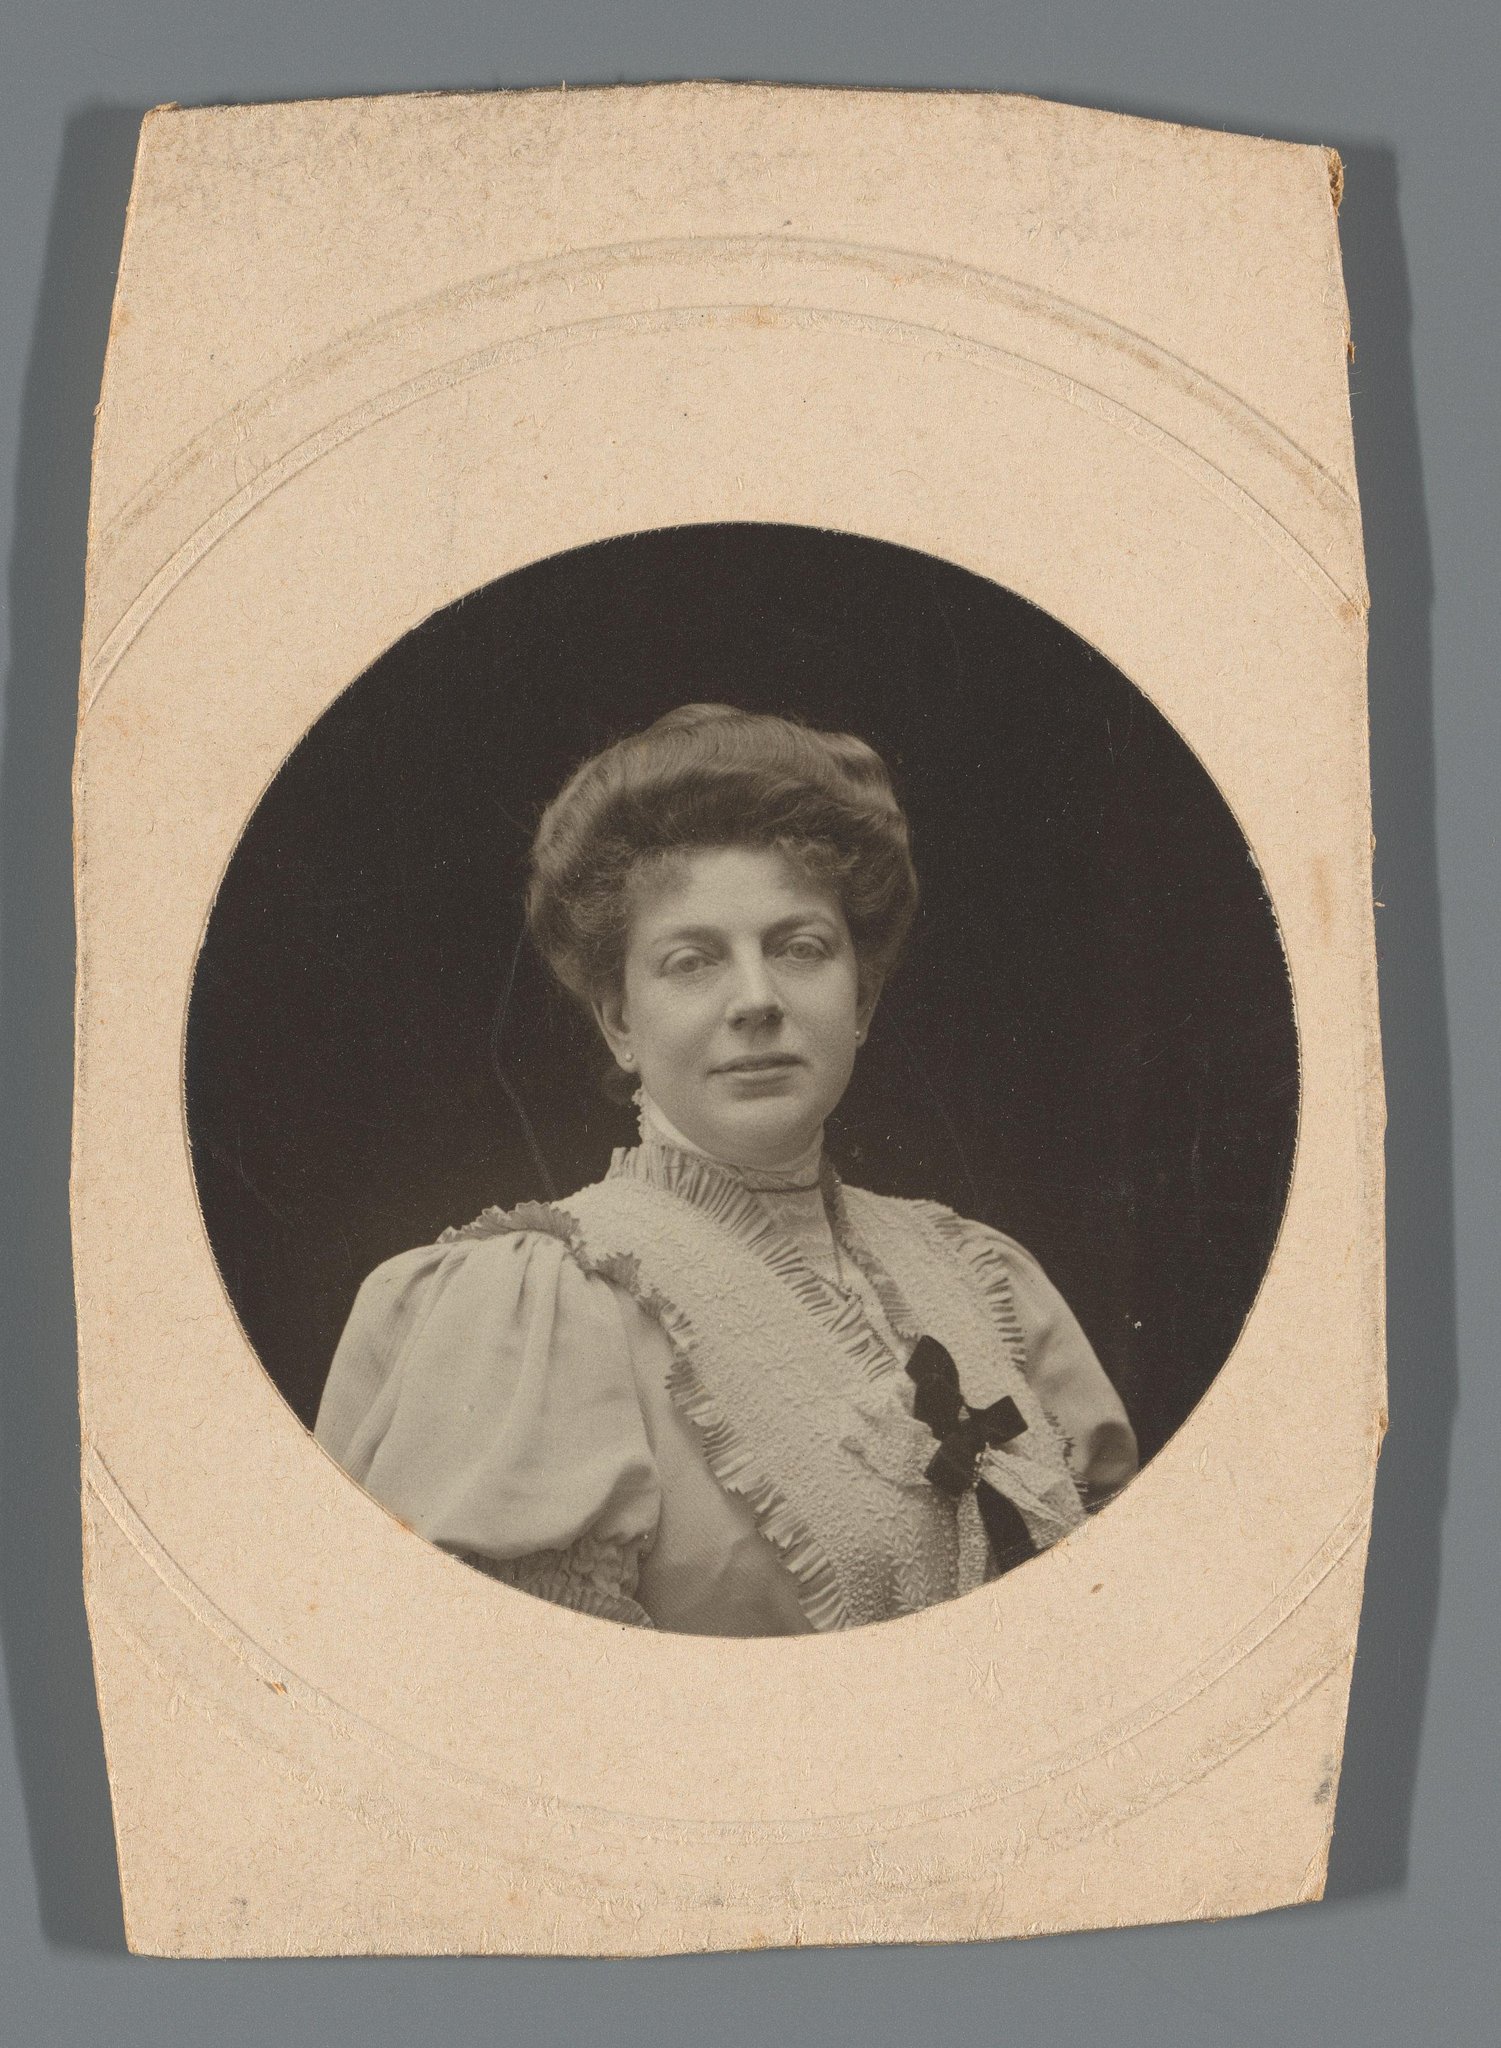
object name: photograph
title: Portret van Pauline van den Berg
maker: Anonymous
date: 1895-1910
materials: cardboard, photographic support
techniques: albumen print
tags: batavia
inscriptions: name: ‘tante Pau’